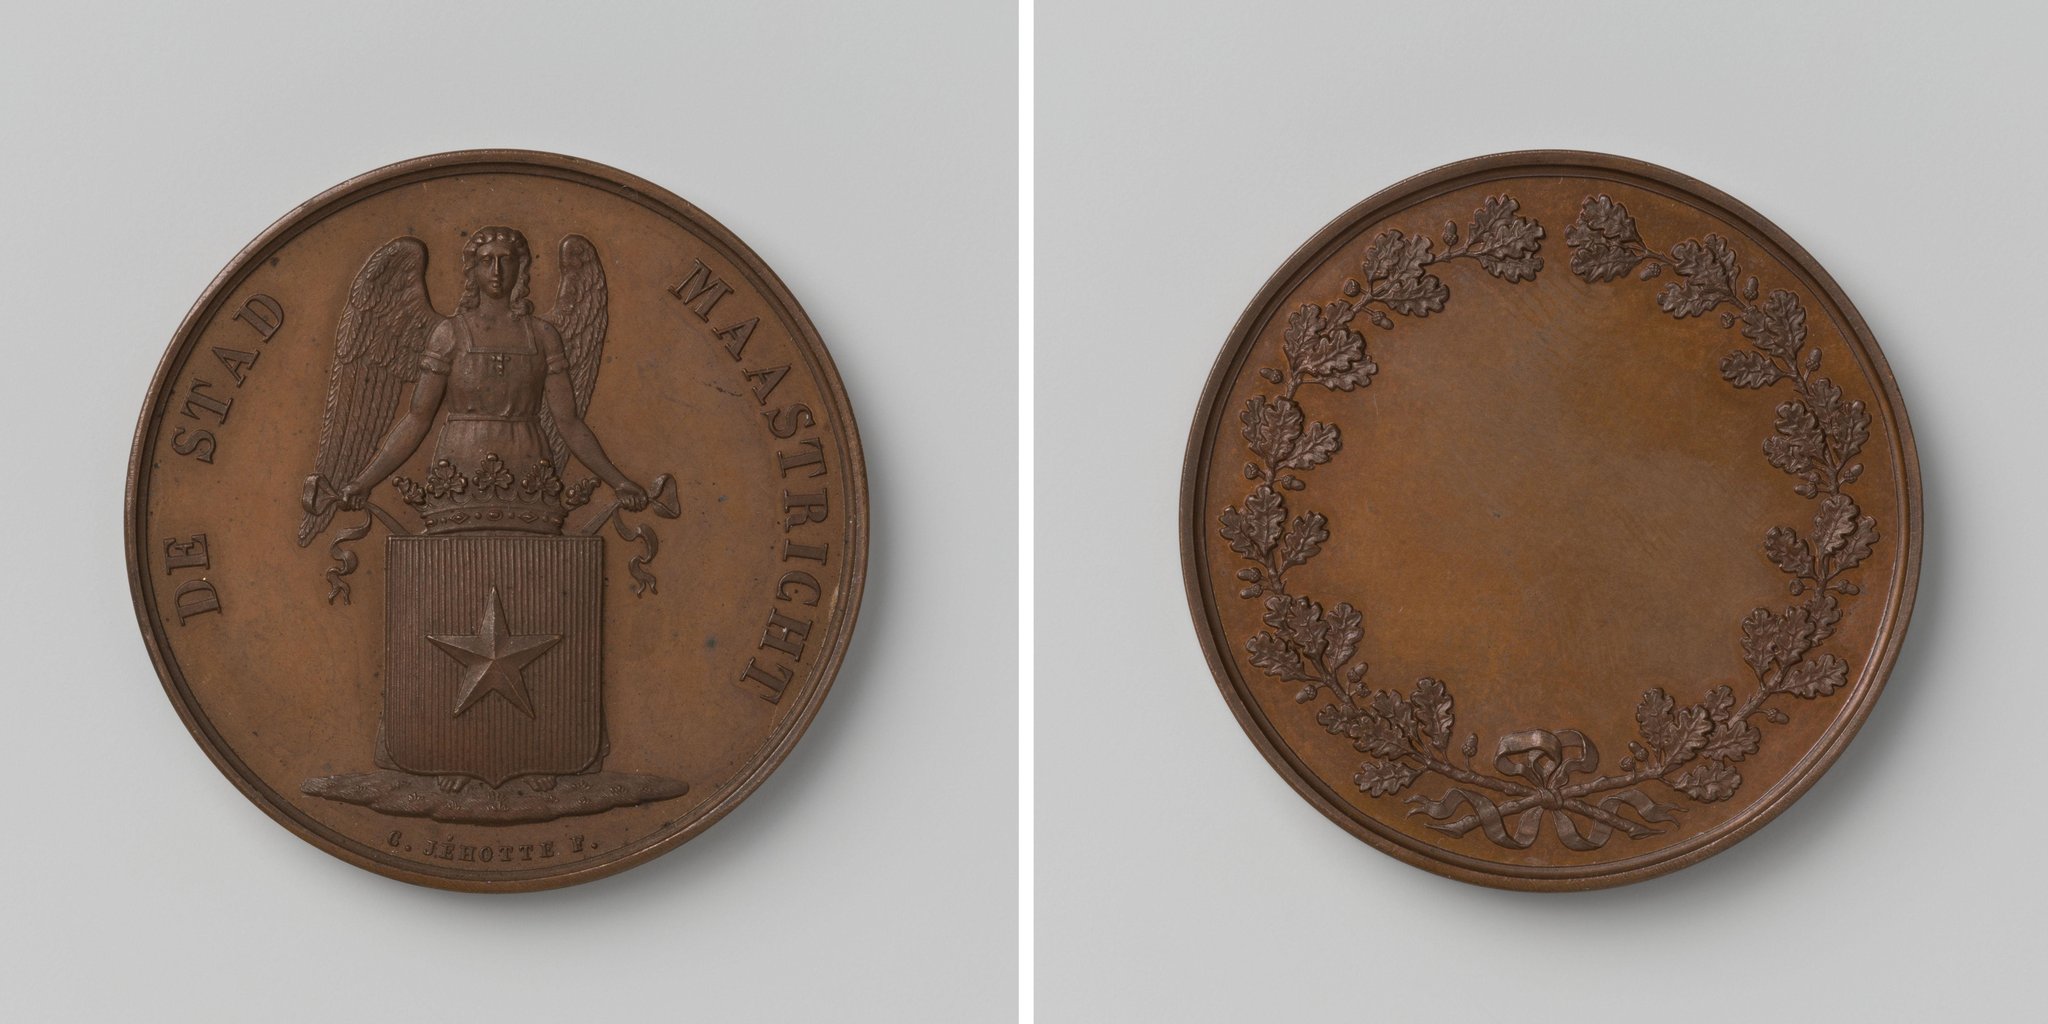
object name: medal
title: Stad Maastricht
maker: constant jéhotte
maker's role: medailleur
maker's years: 1809-1882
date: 1847-1853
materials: bronze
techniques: striking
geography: liège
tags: maastricht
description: Bronzen penning. Voorzijde: engel houdt aan twee linten gebonden, gekroond wapenschild voor zich binnen omschrift. Keerzijde: blanco veld binnen eikekrans